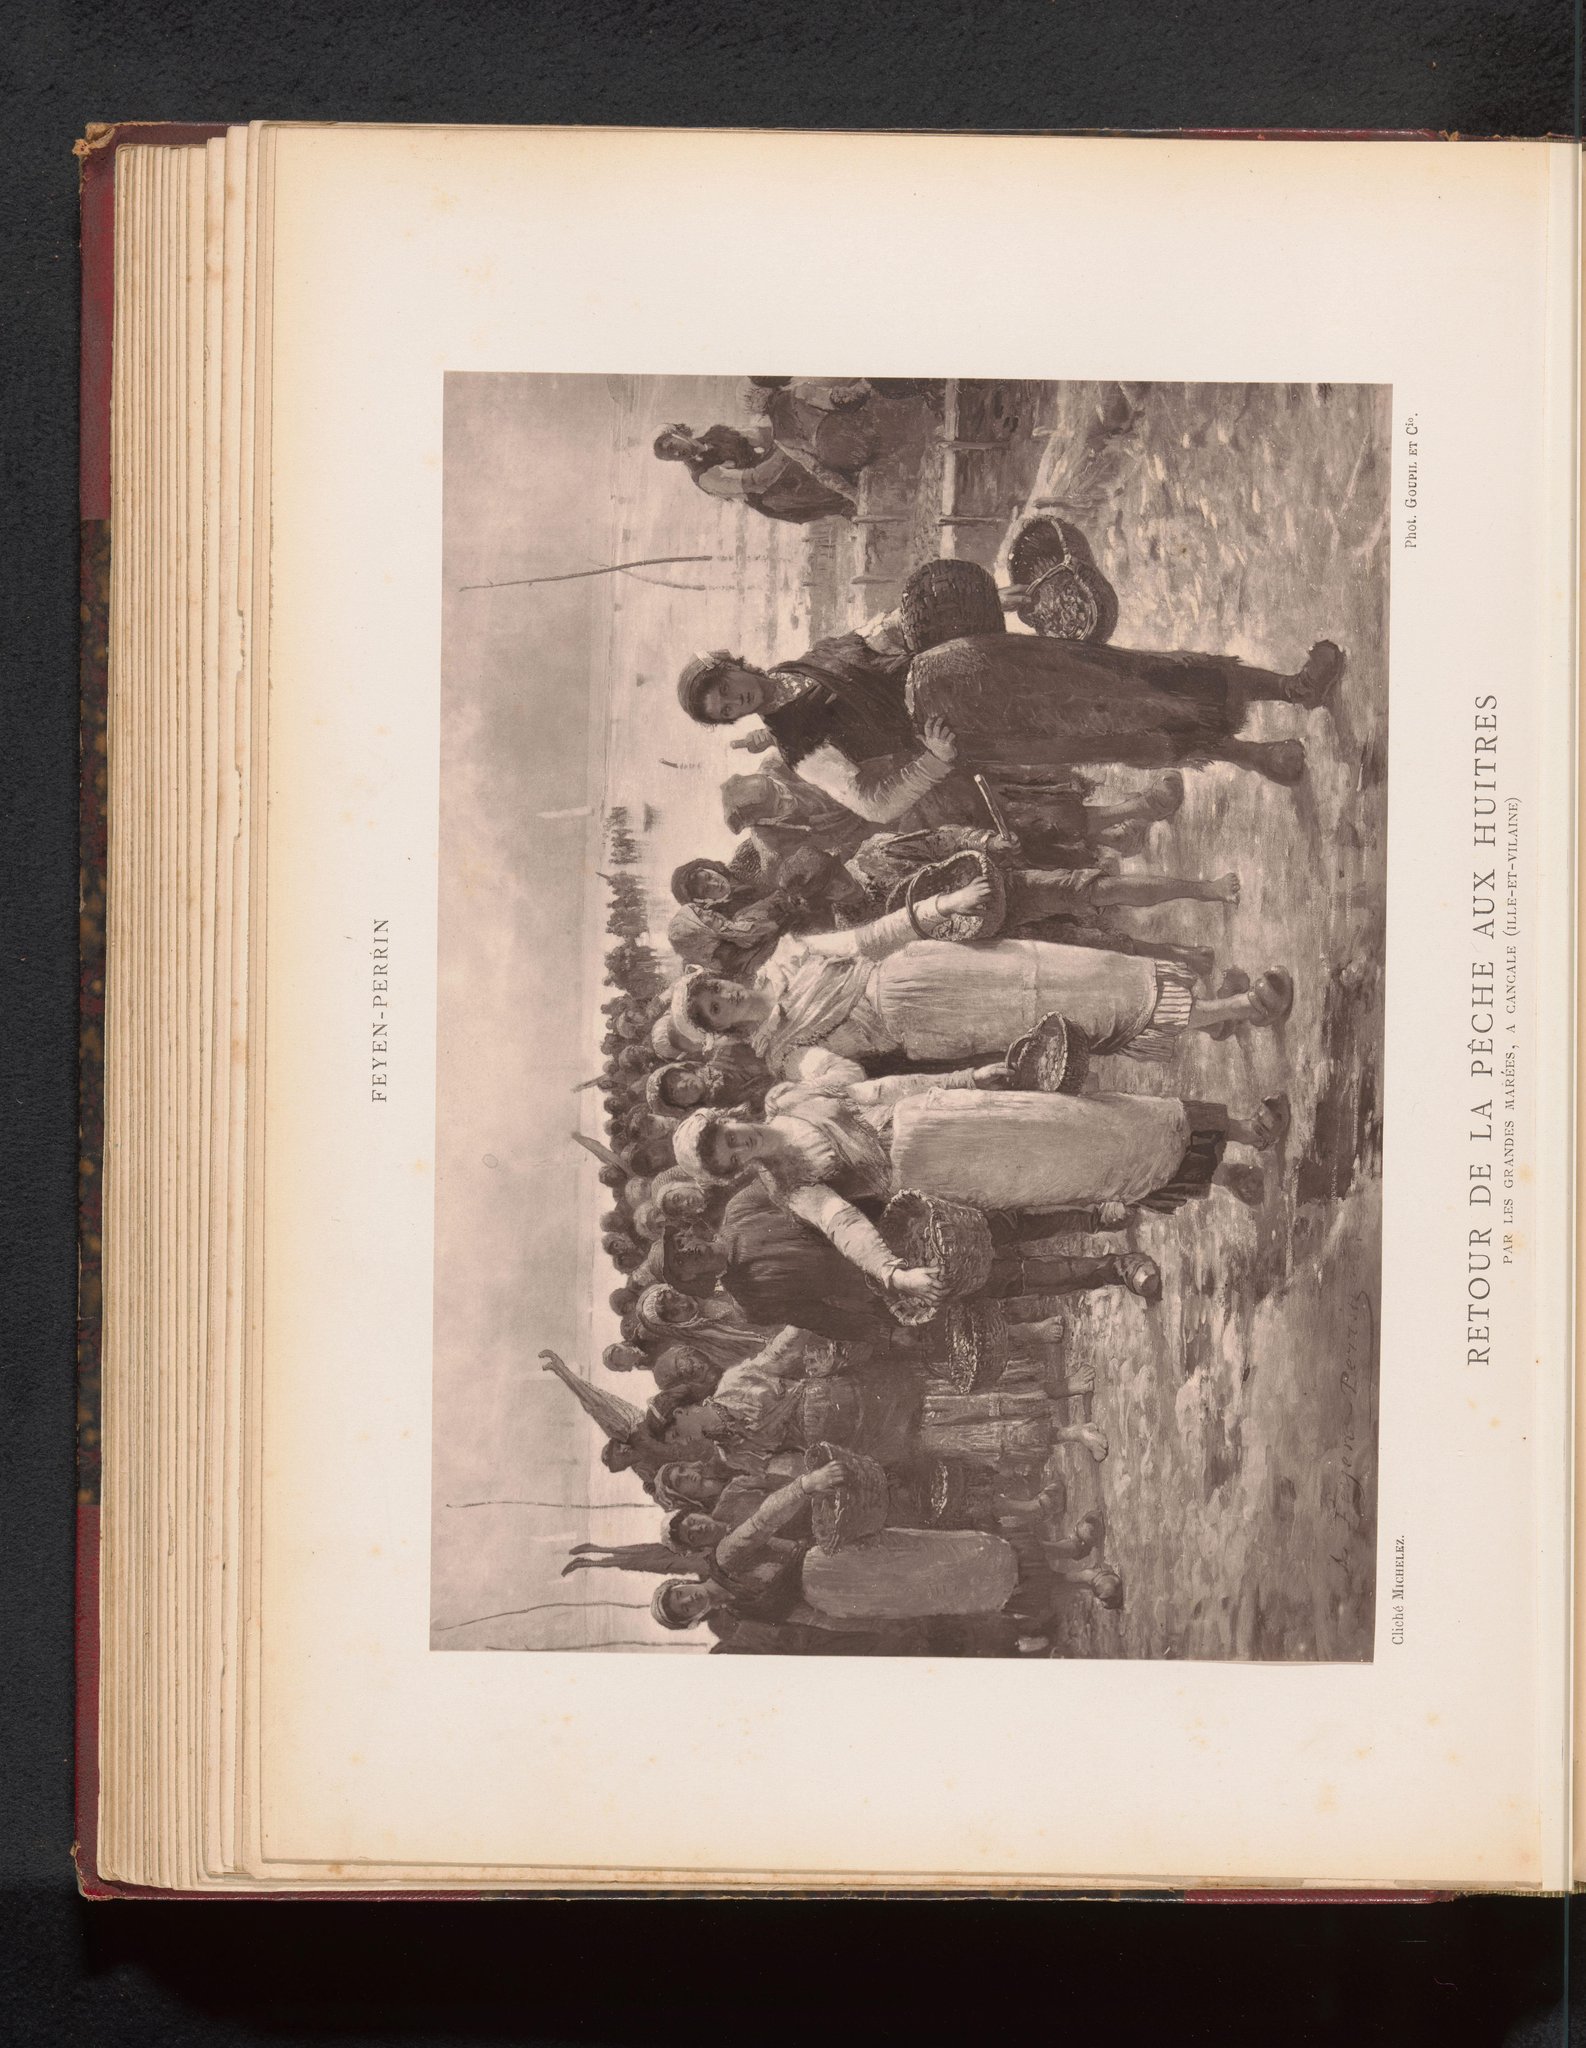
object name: page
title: Retour de la pêche aux huitres - par les grandes marées, à Cancale (Ille-et-vilaine)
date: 1871-1876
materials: paper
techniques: woodburytype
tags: adult woman, oyster and mussel culture, painting, drawing and the graphic arts